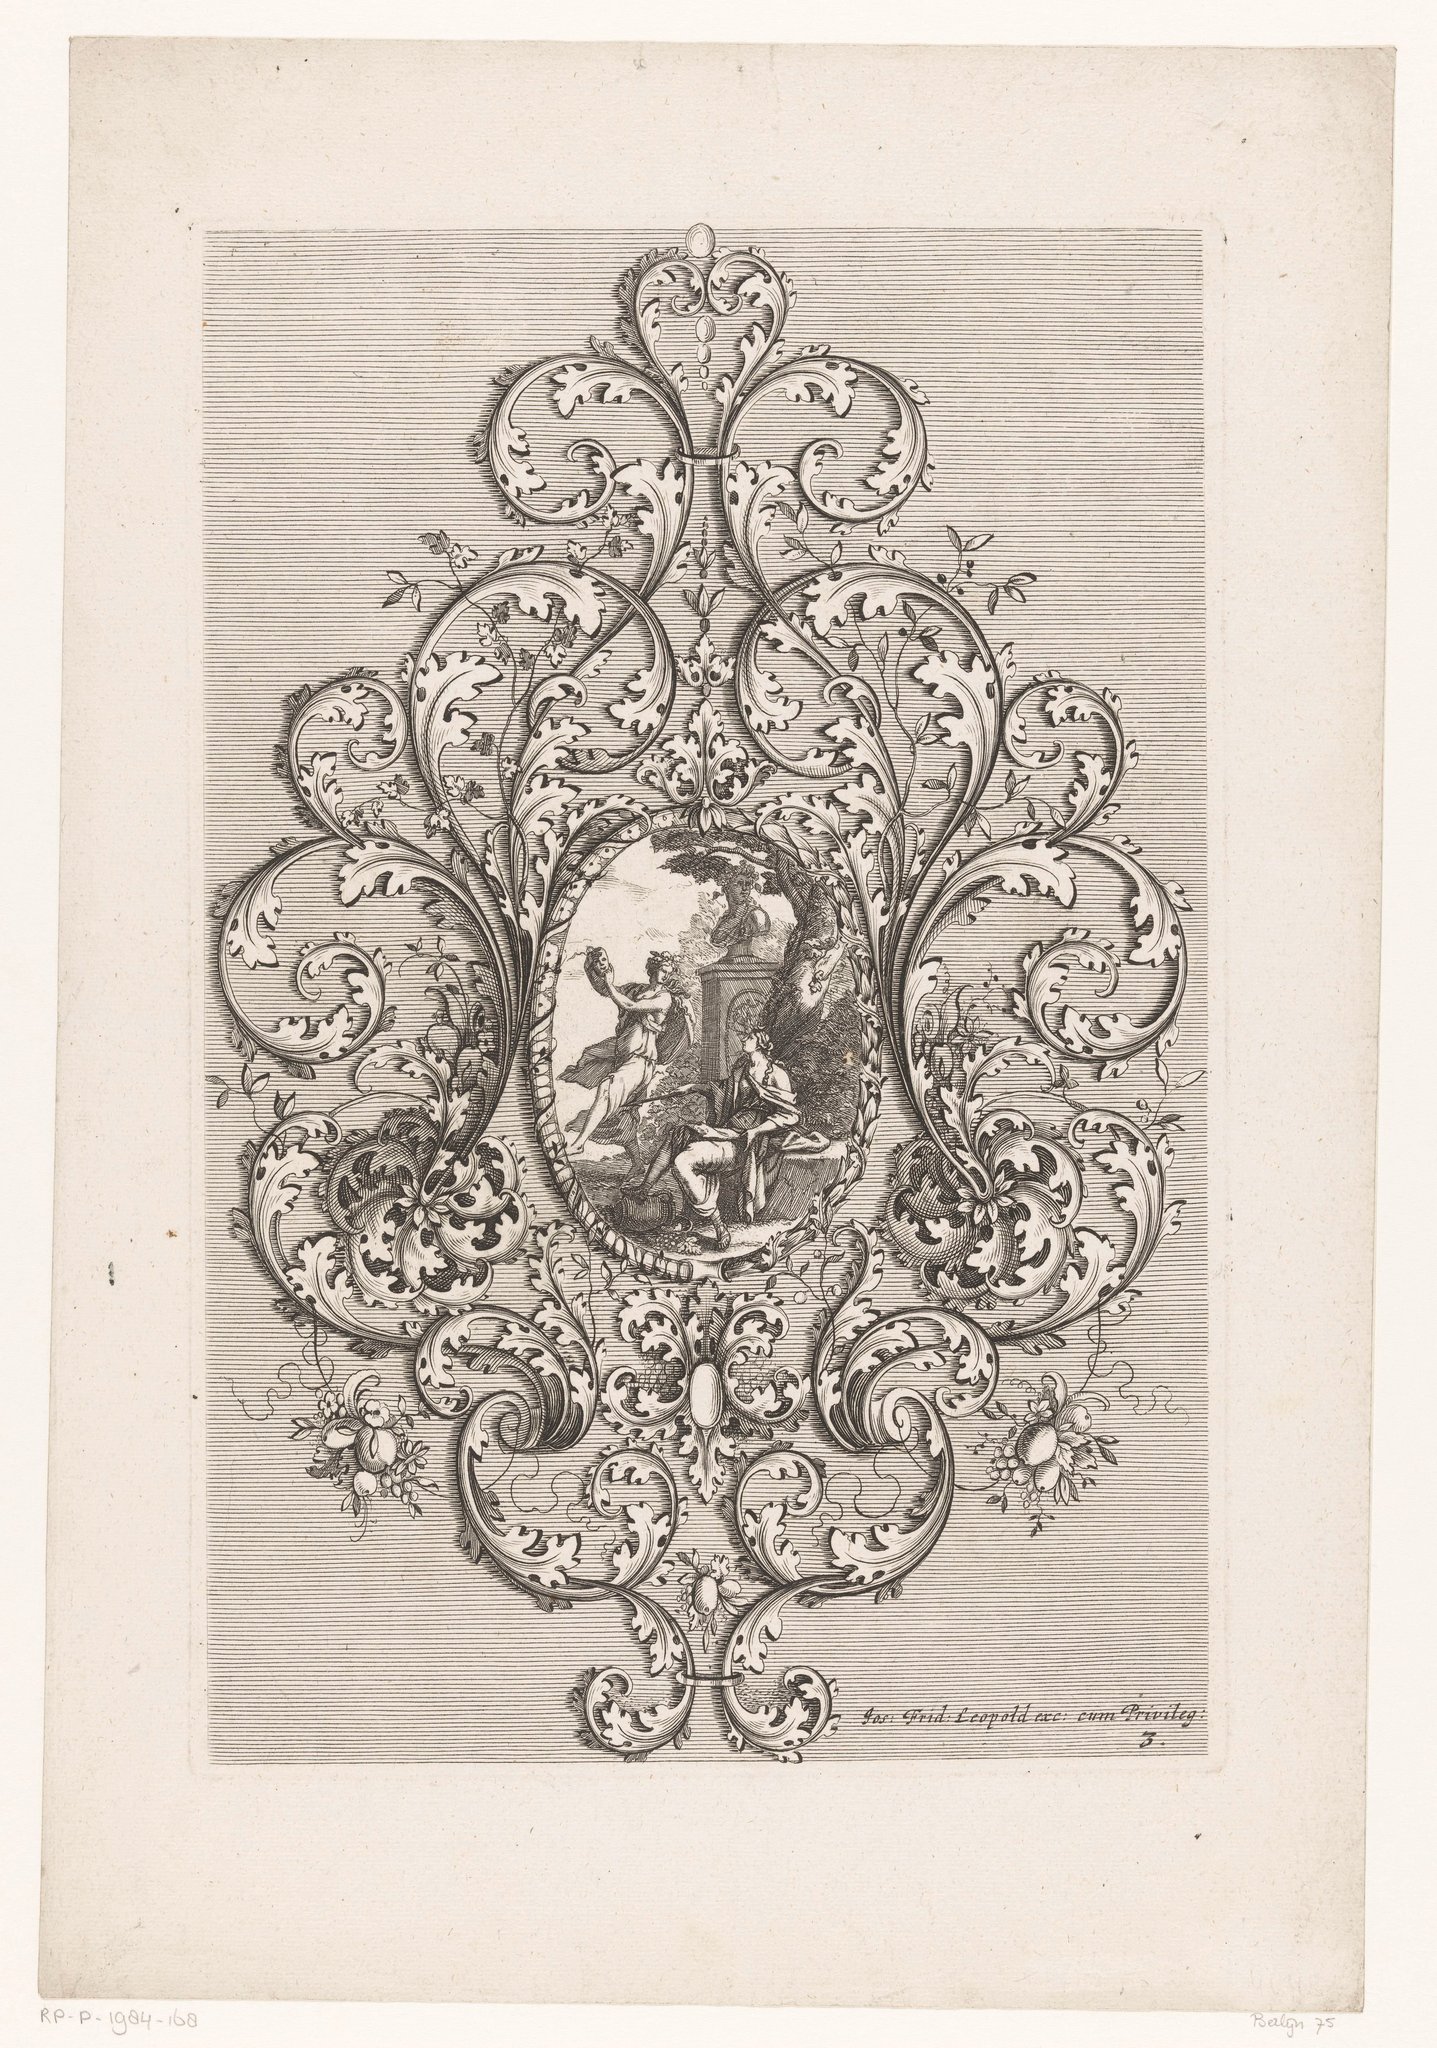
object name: ornament print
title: Medaillon met Diana en nimf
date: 1697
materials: paper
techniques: engraving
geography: augsburg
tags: (story of) diana (artemis), nymphs (in general); 'ninfe in commune' (ripa), ornament ~ cartouche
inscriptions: collector's mark: Lugt 2228, collector's mark: Lugt 2760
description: Een ovaal medaillon omgeven door acanthusranken en fruit. In het medaillon een landschap met Diana en een dansende nimf naast een buste van Bacchus op een voetstuk.